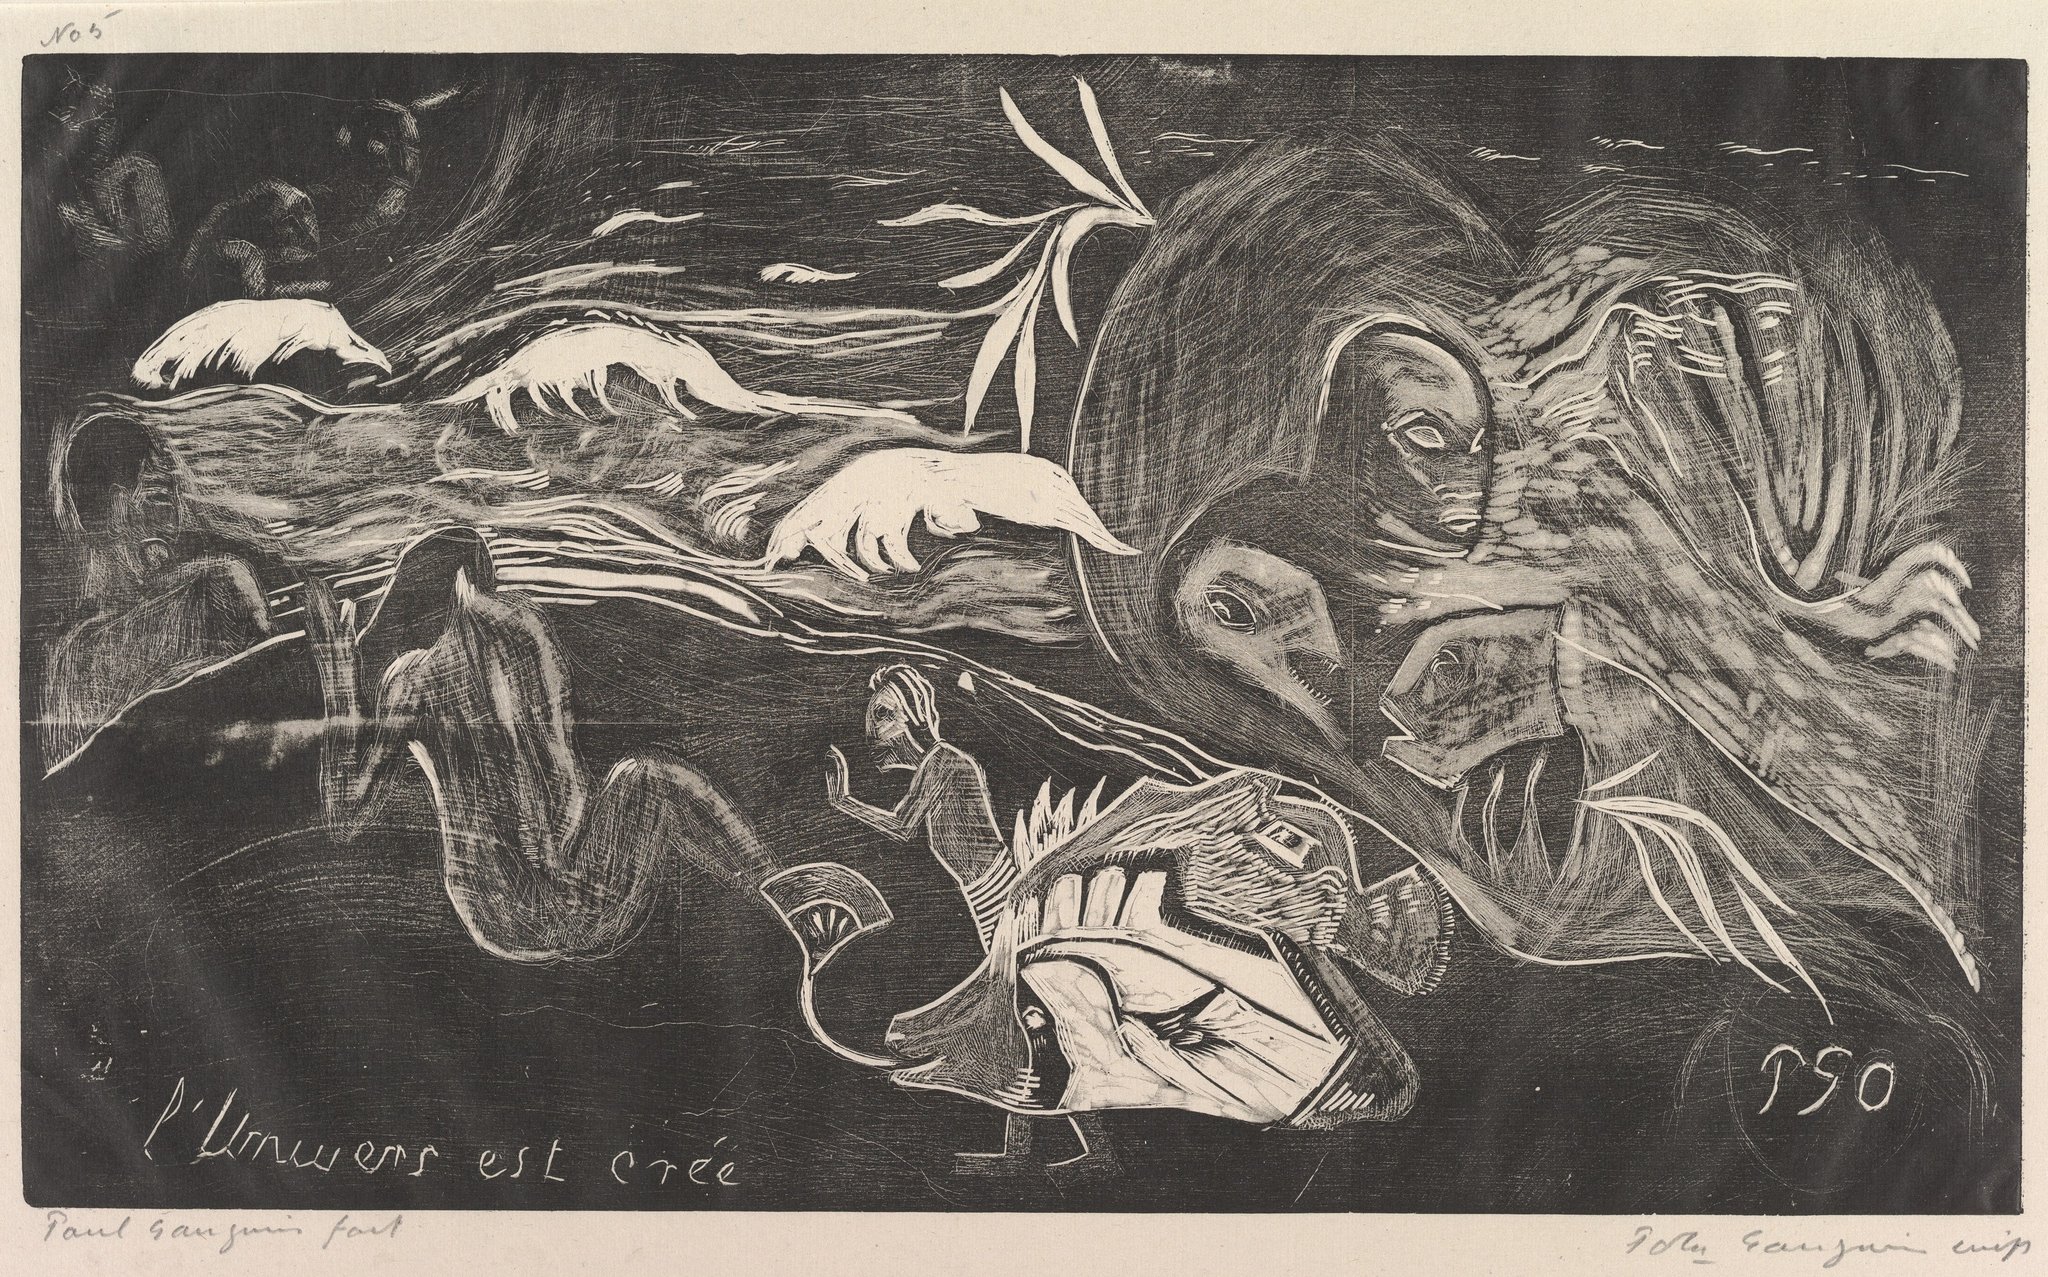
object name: print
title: The Universe is Created (L'Univers est créé), from Fragrance (Noa Noa)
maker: paul gauguin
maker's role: artist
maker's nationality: french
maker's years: 1848-1903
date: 1893-1894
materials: paper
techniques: woodcut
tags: abstraction